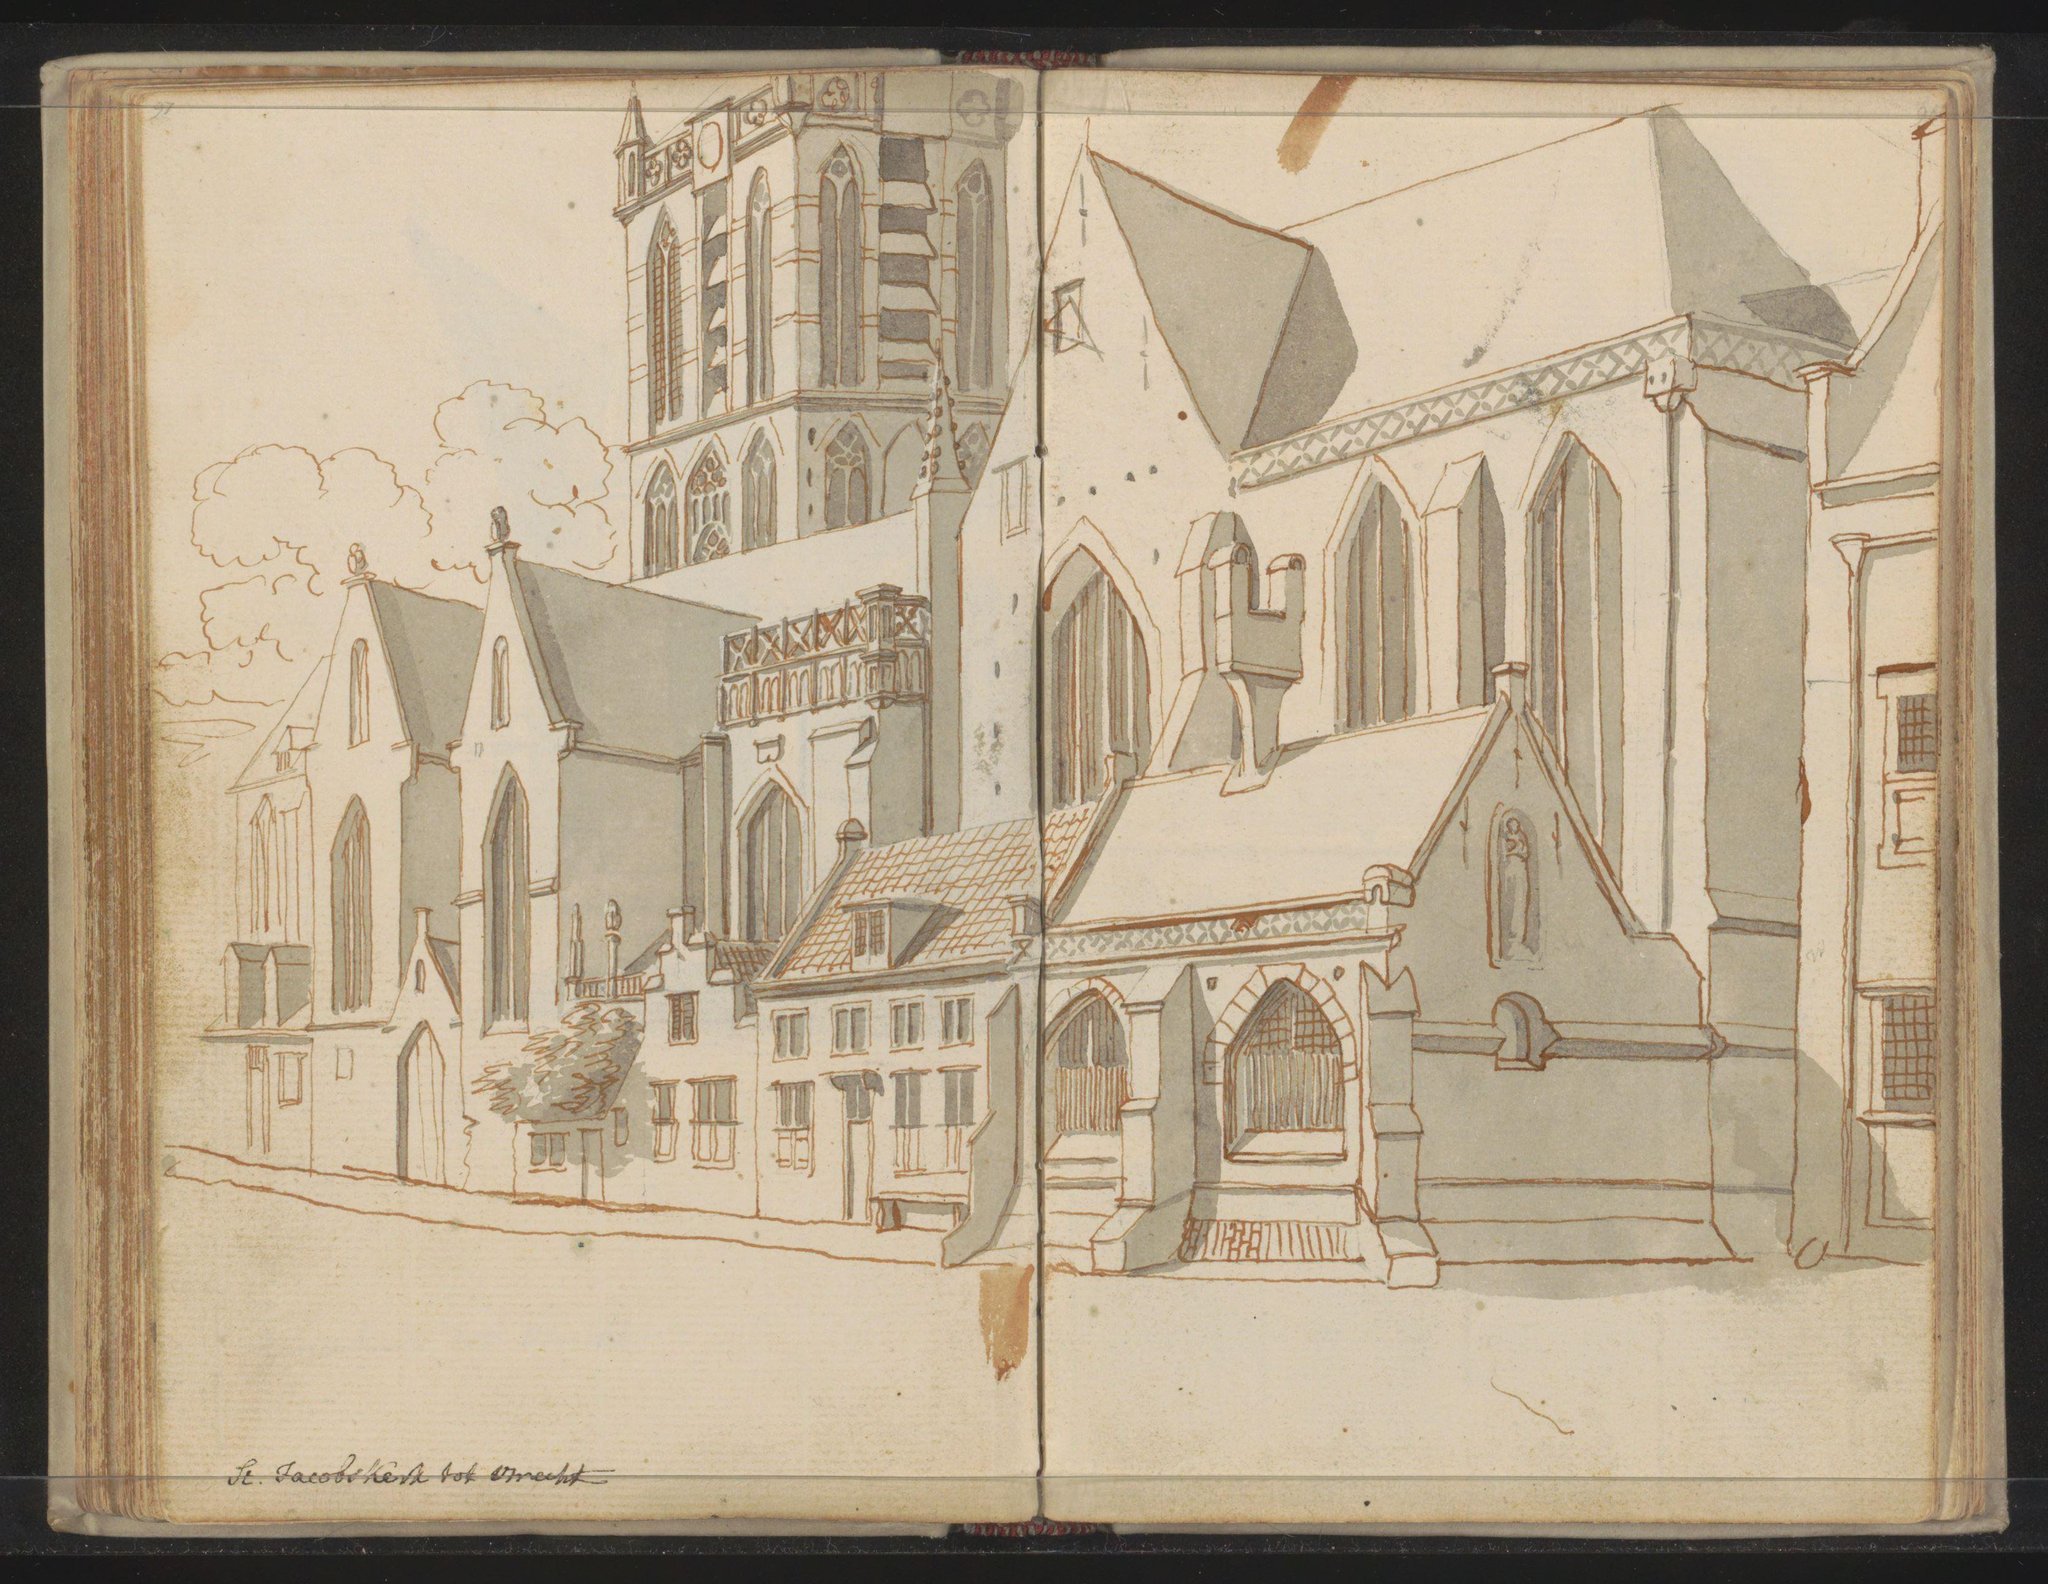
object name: sketchbook leaf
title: Rechtergevel van de Jacobikerk te Utrecht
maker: johannes huibert prins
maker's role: draughtsman, painter, print maker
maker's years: 1757-1806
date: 1783-1797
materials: ink, paper, pencil, watercolor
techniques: brush, pen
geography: utrecht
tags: church (exterior)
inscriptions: annotation: ‘St. Jacobskerk tot Utrecht’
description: Pagina 97 en 98 uit een schetsboek met 175 pagina's.